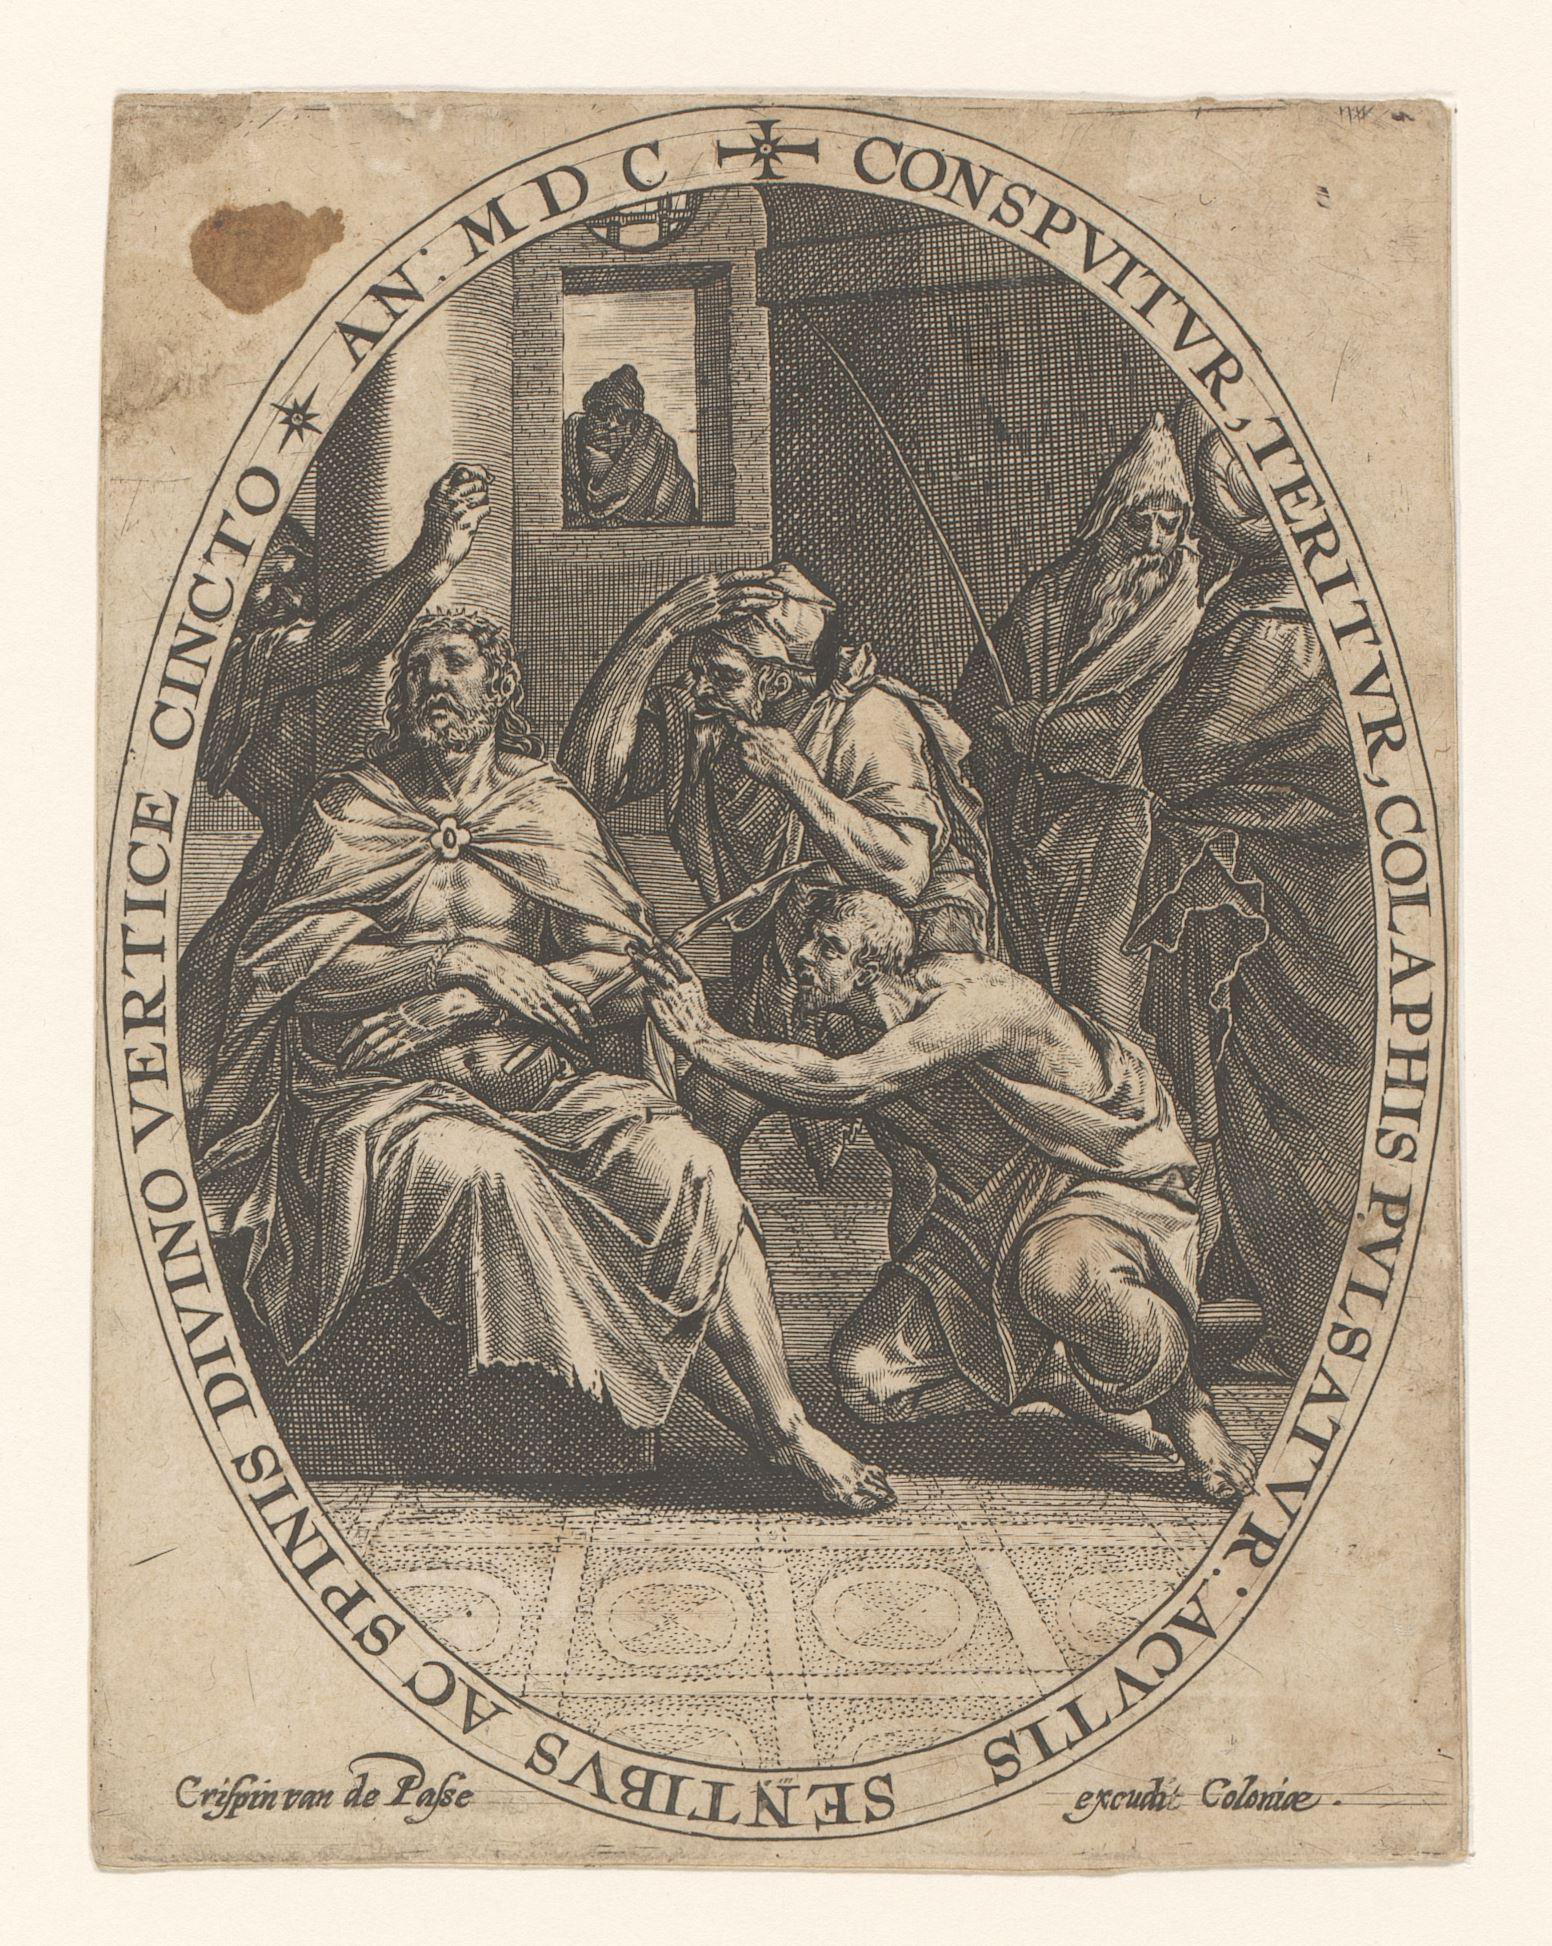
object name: print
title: Passie van Christus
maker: crispijn van de passe (i)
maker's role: draughtsman, print maker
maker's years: 1564-1637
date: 1600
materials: paper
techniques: engraving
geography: cologne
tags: in pilate's palace christ is mocked by soldiers (luke 22:63-65)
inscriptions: collector's mark: Lugt 2228